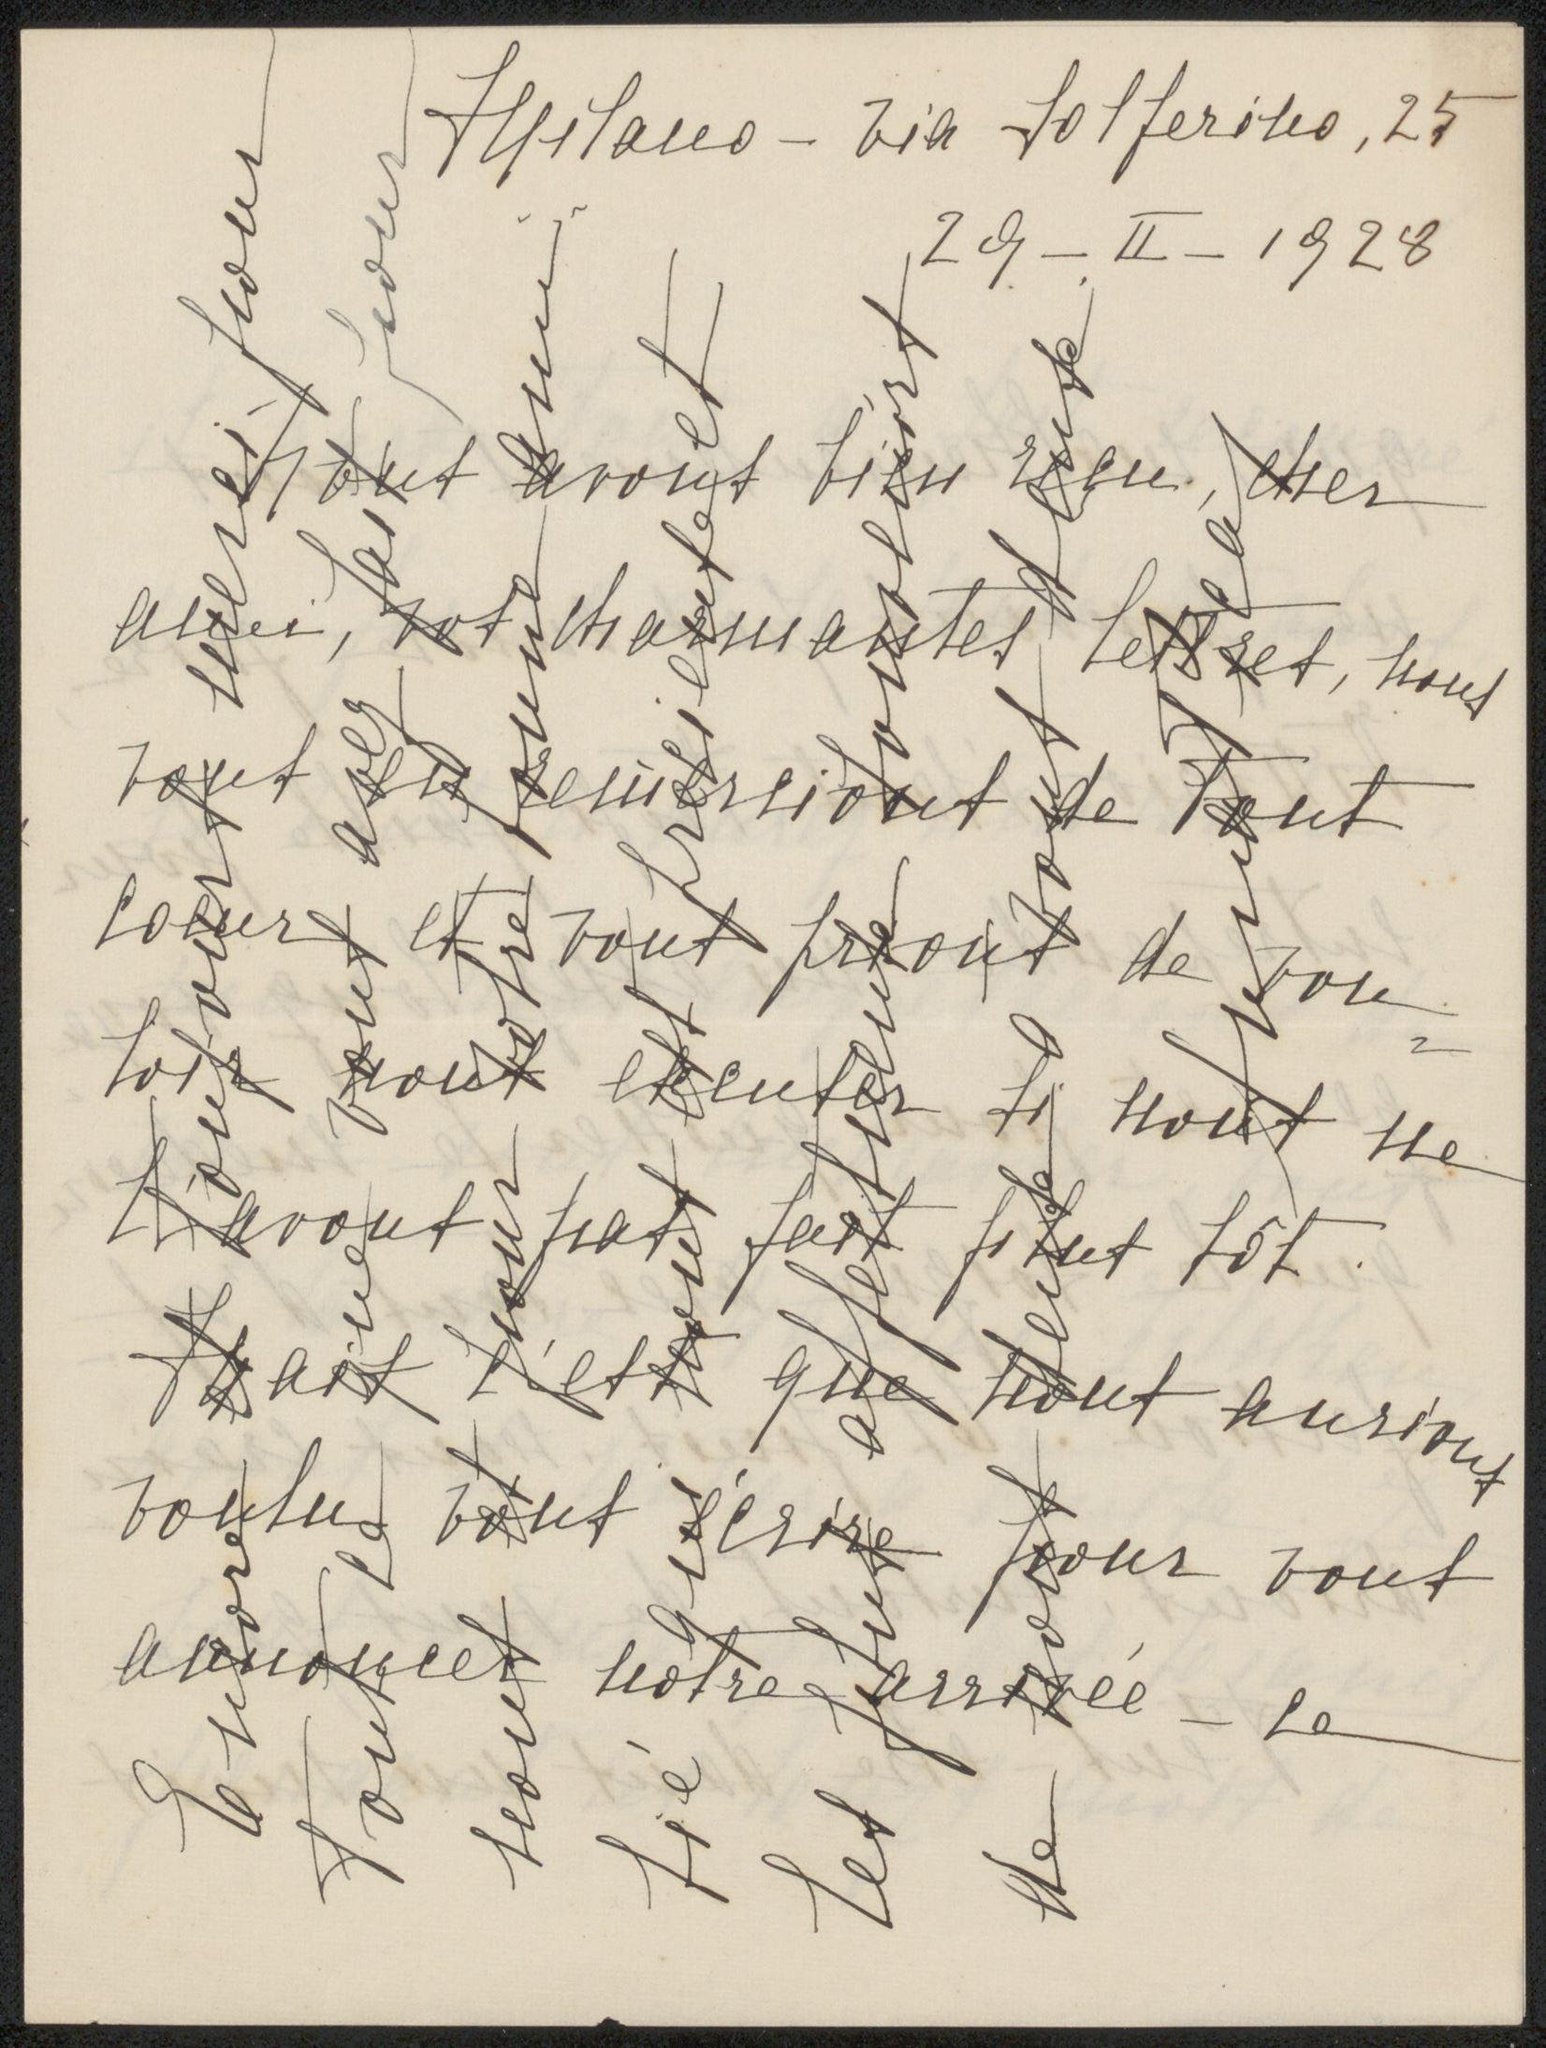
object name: letter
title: Brief aan Philip Zilcken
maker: anna pica-marazzani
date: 1928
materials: ink, paper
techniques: pen, writing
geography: milan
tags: vittorio pica, painter, draughtsman, philip zilcken, travelling; tourism, diseases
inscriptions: collector's mark: ‘RPK’